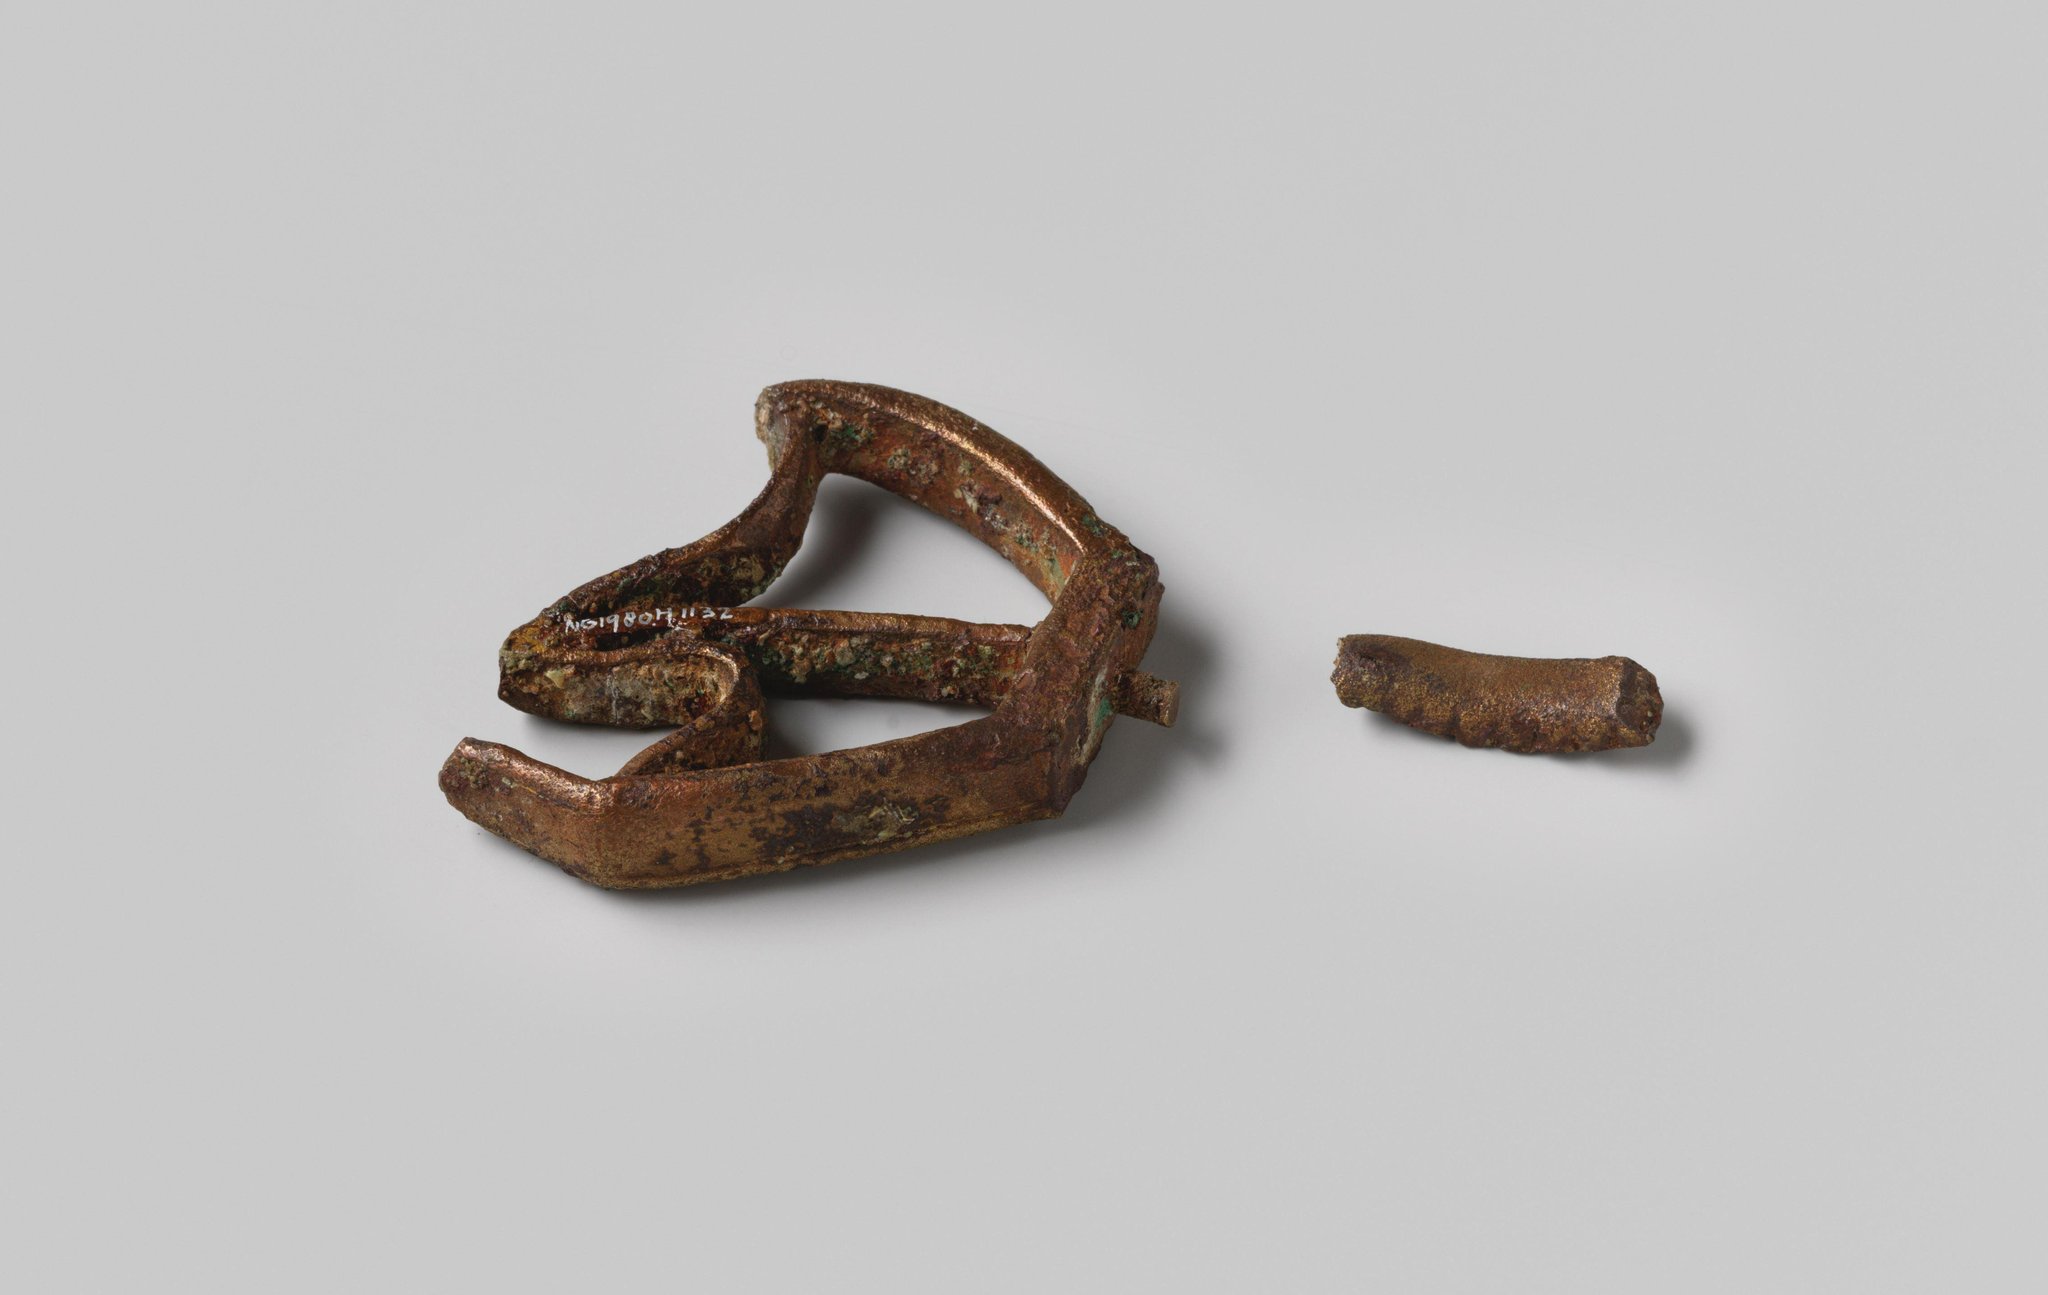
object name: fragment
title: Fragmenten van koper uit het wrak van de Oost-Indiëvaarder Hollandia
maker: Anonymous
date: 1700-1743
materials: copper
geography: netherlands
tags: verenigde oostindische compagnie, hollandia (schip), annet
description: Varied parts or fragments; unidentified and miscellaneous parts or fragments.